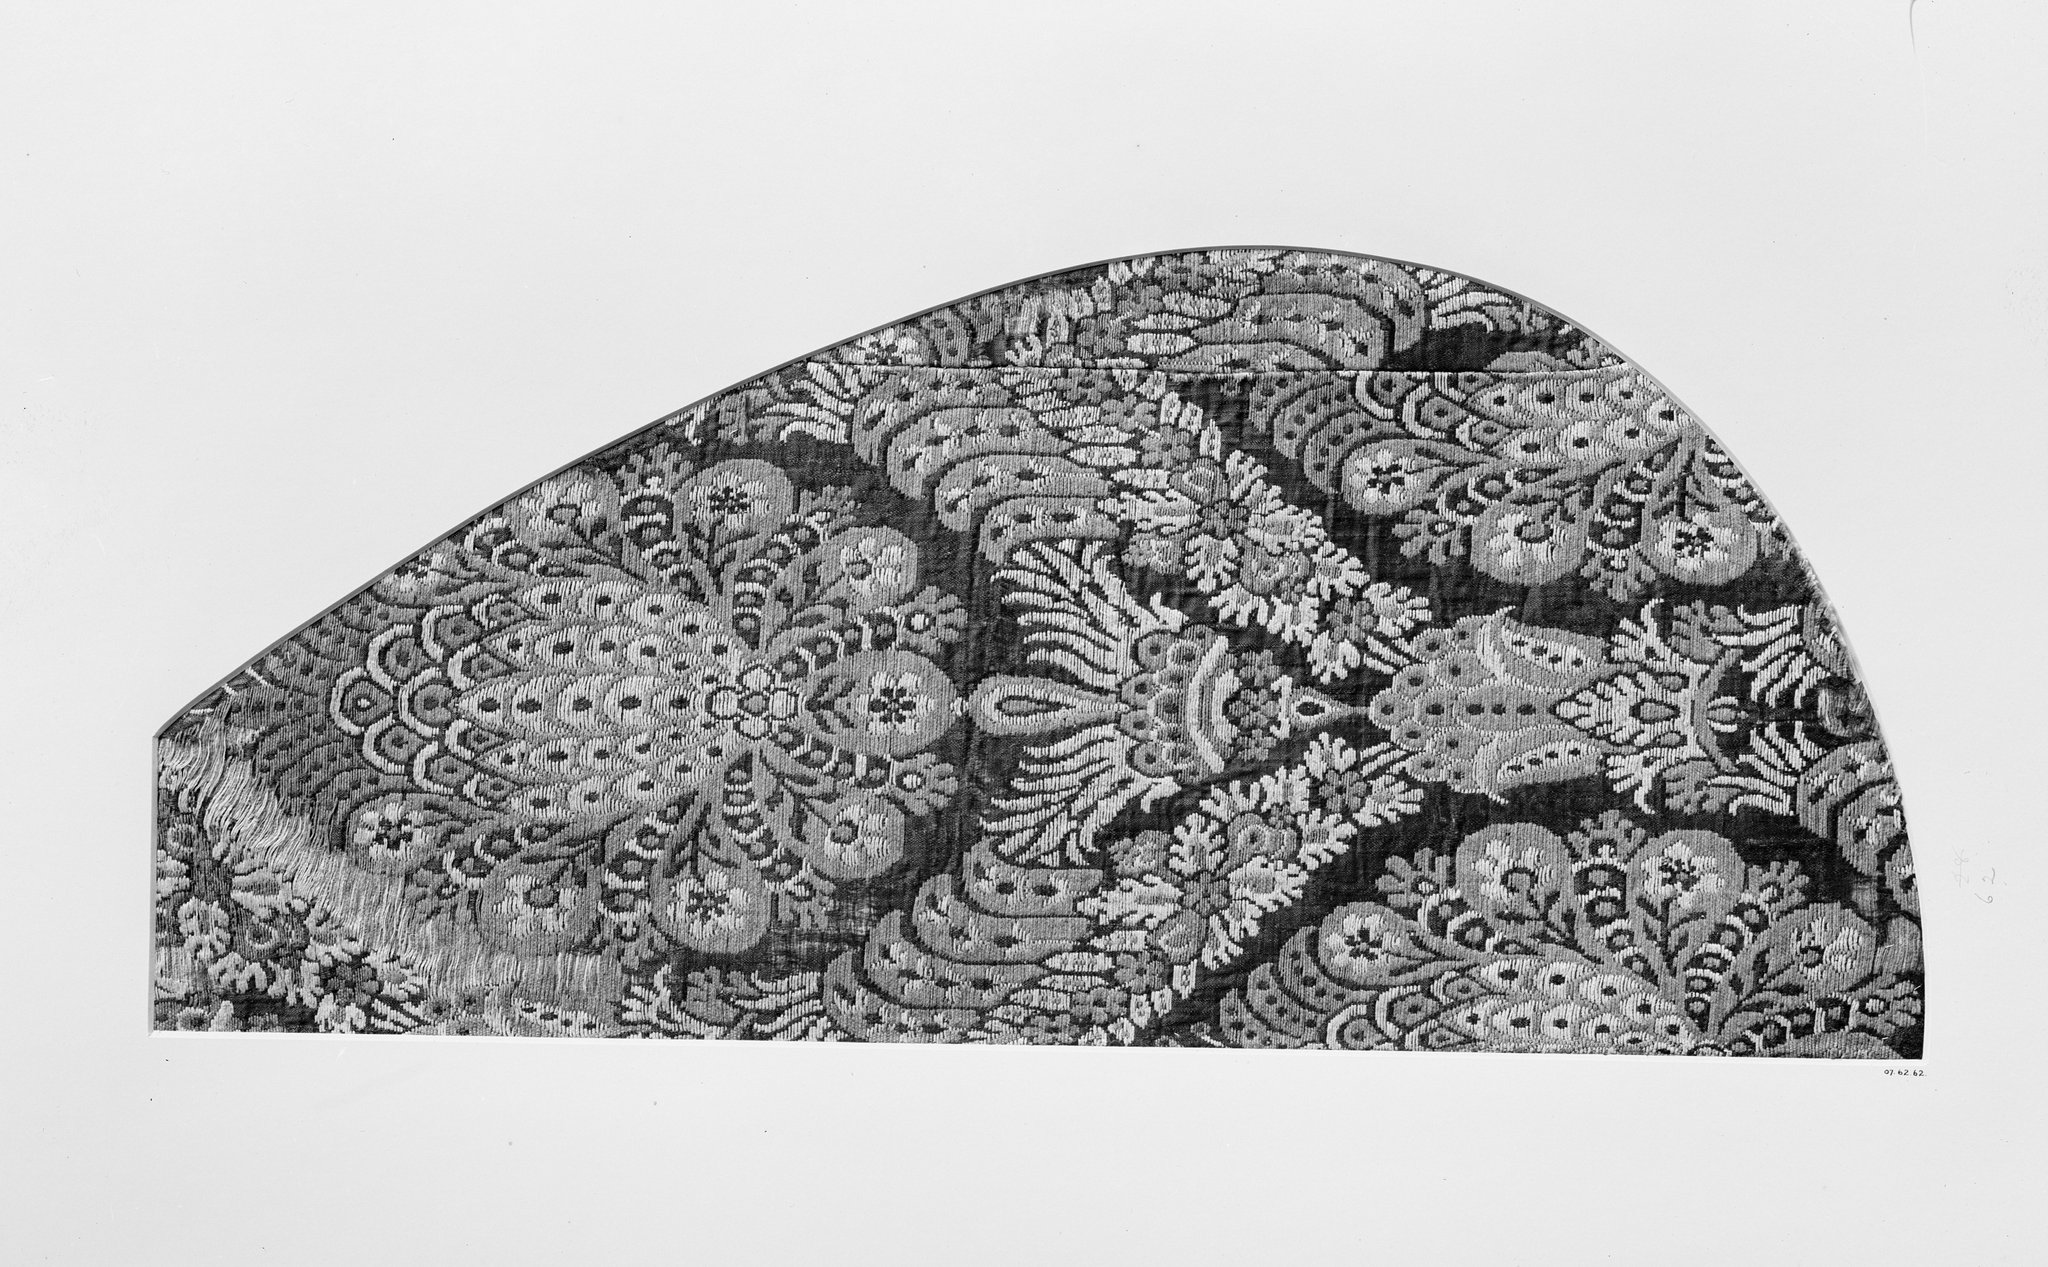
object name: piece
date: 1695-1705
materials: cotton, linen, silk